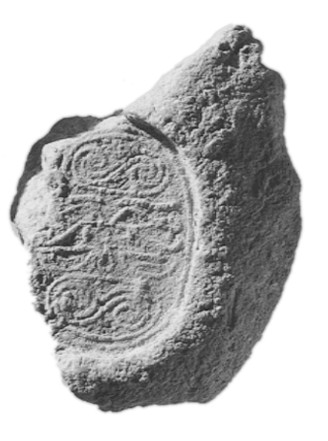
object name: sealing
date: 2030-1640 BCE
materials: clay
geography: egypt